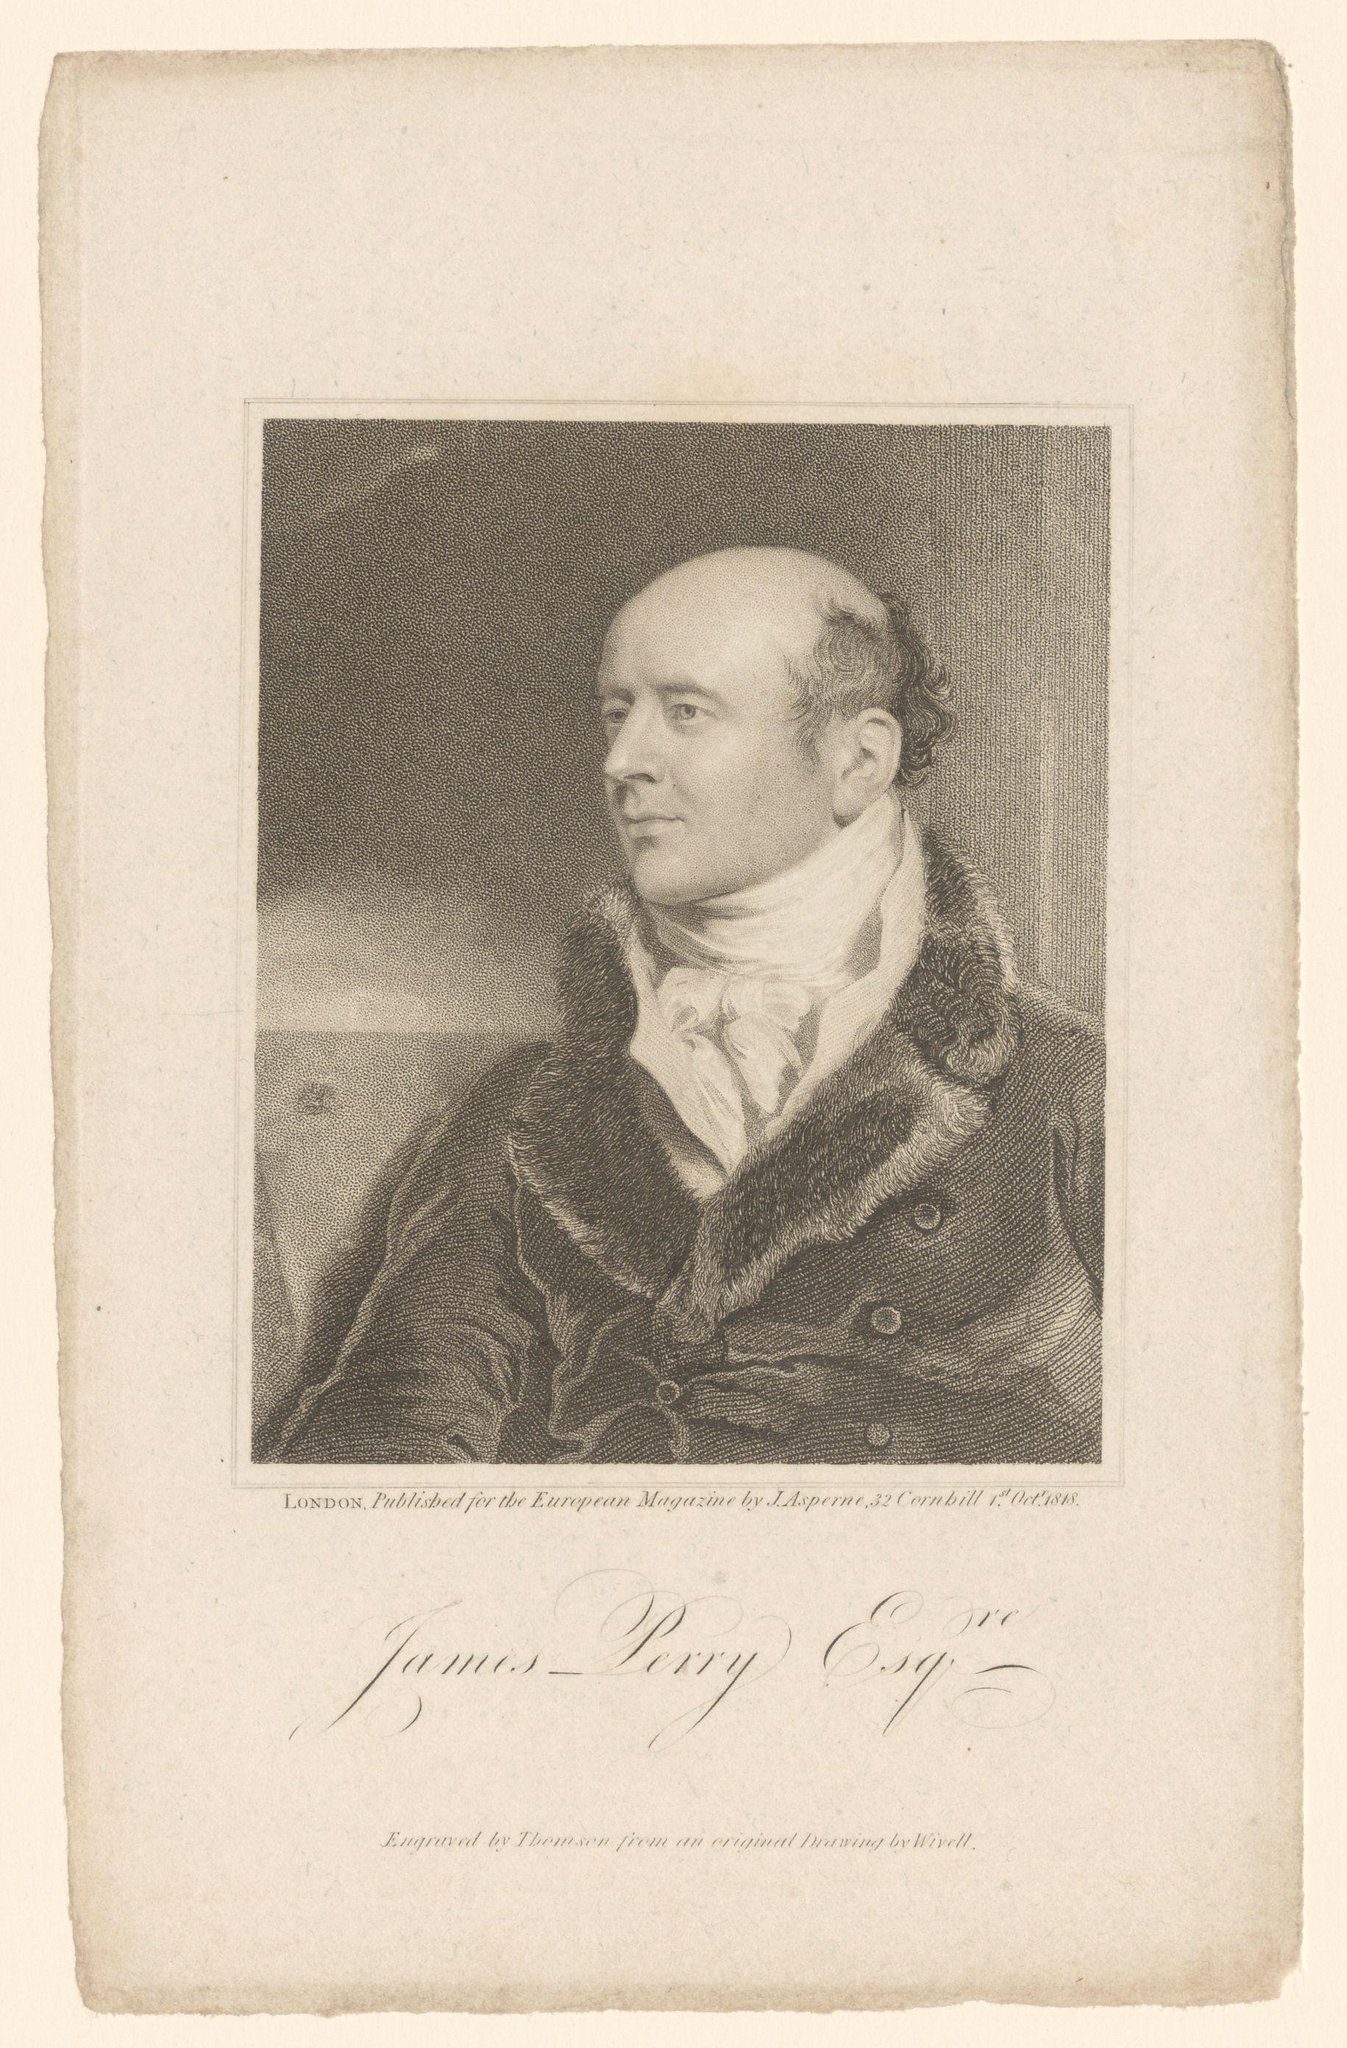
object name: print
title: James Perry Esqre.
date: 1810-1818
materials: paper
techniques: etching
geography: london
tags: journalist, reporter, historical persons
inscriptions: collector's mark: Lugt 2228